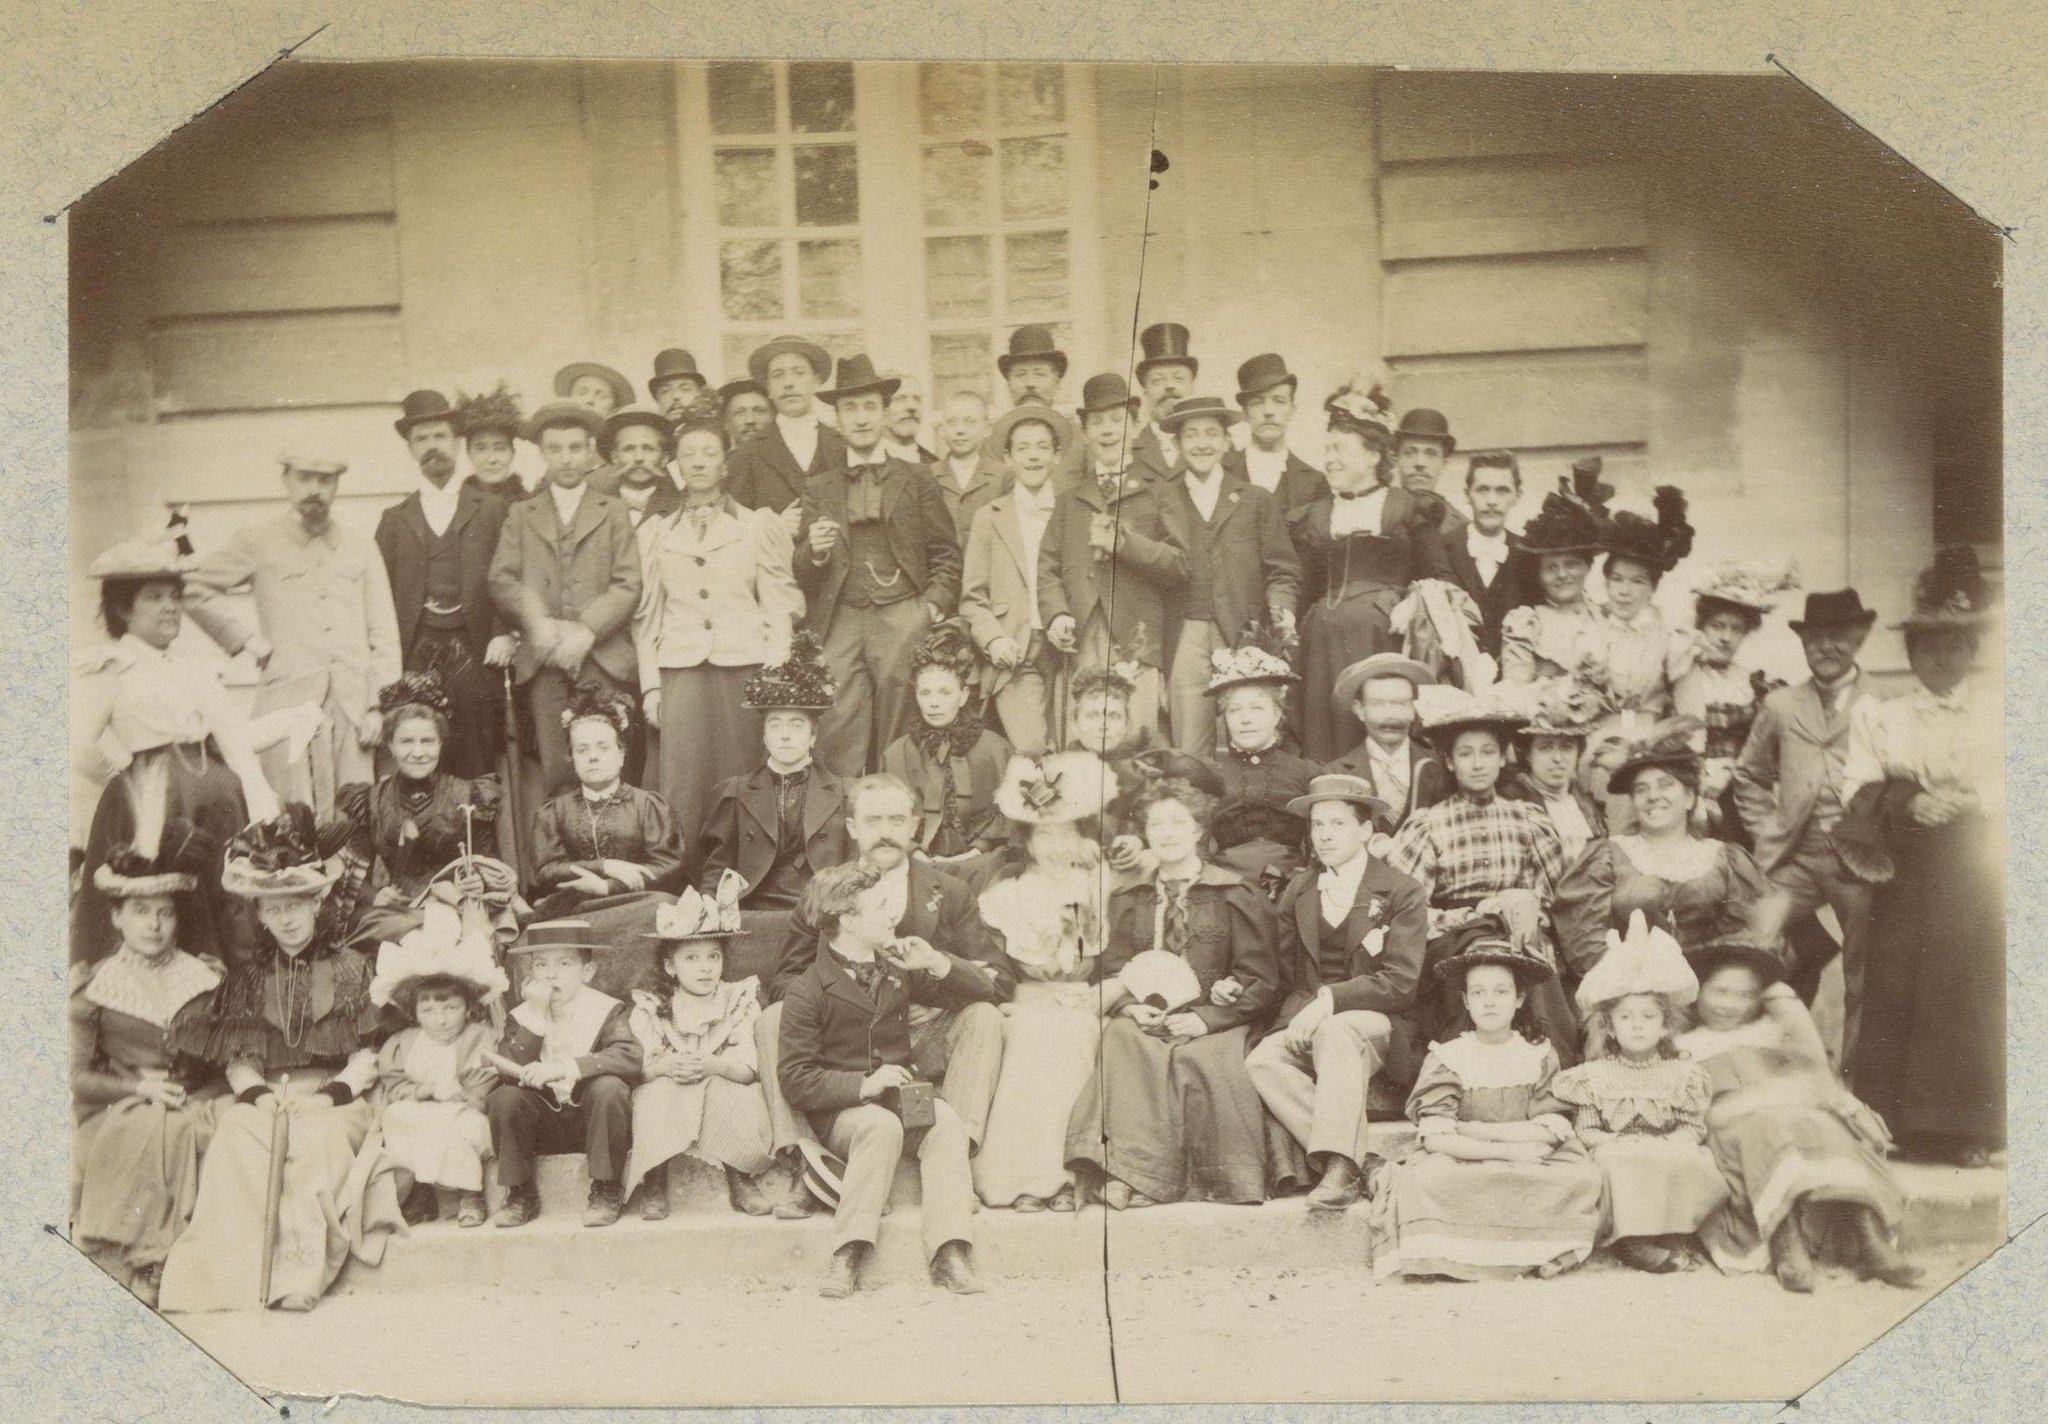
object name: photograph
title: Groepsportret van oud-leerlingen ('l'Association amicale des anciens élèves') tijdens een excursie naar Chantilly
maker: Anonymous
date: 1898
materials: paper, photographic support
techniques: albumen print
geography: france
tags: outing, pleasure trip, france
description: Onderdeel van Album van een Franse amateur met foto's van Frankrijk, Algerije, Palmyra, de Wereldtentoonstelling van 1900 en van bekende Fransen.